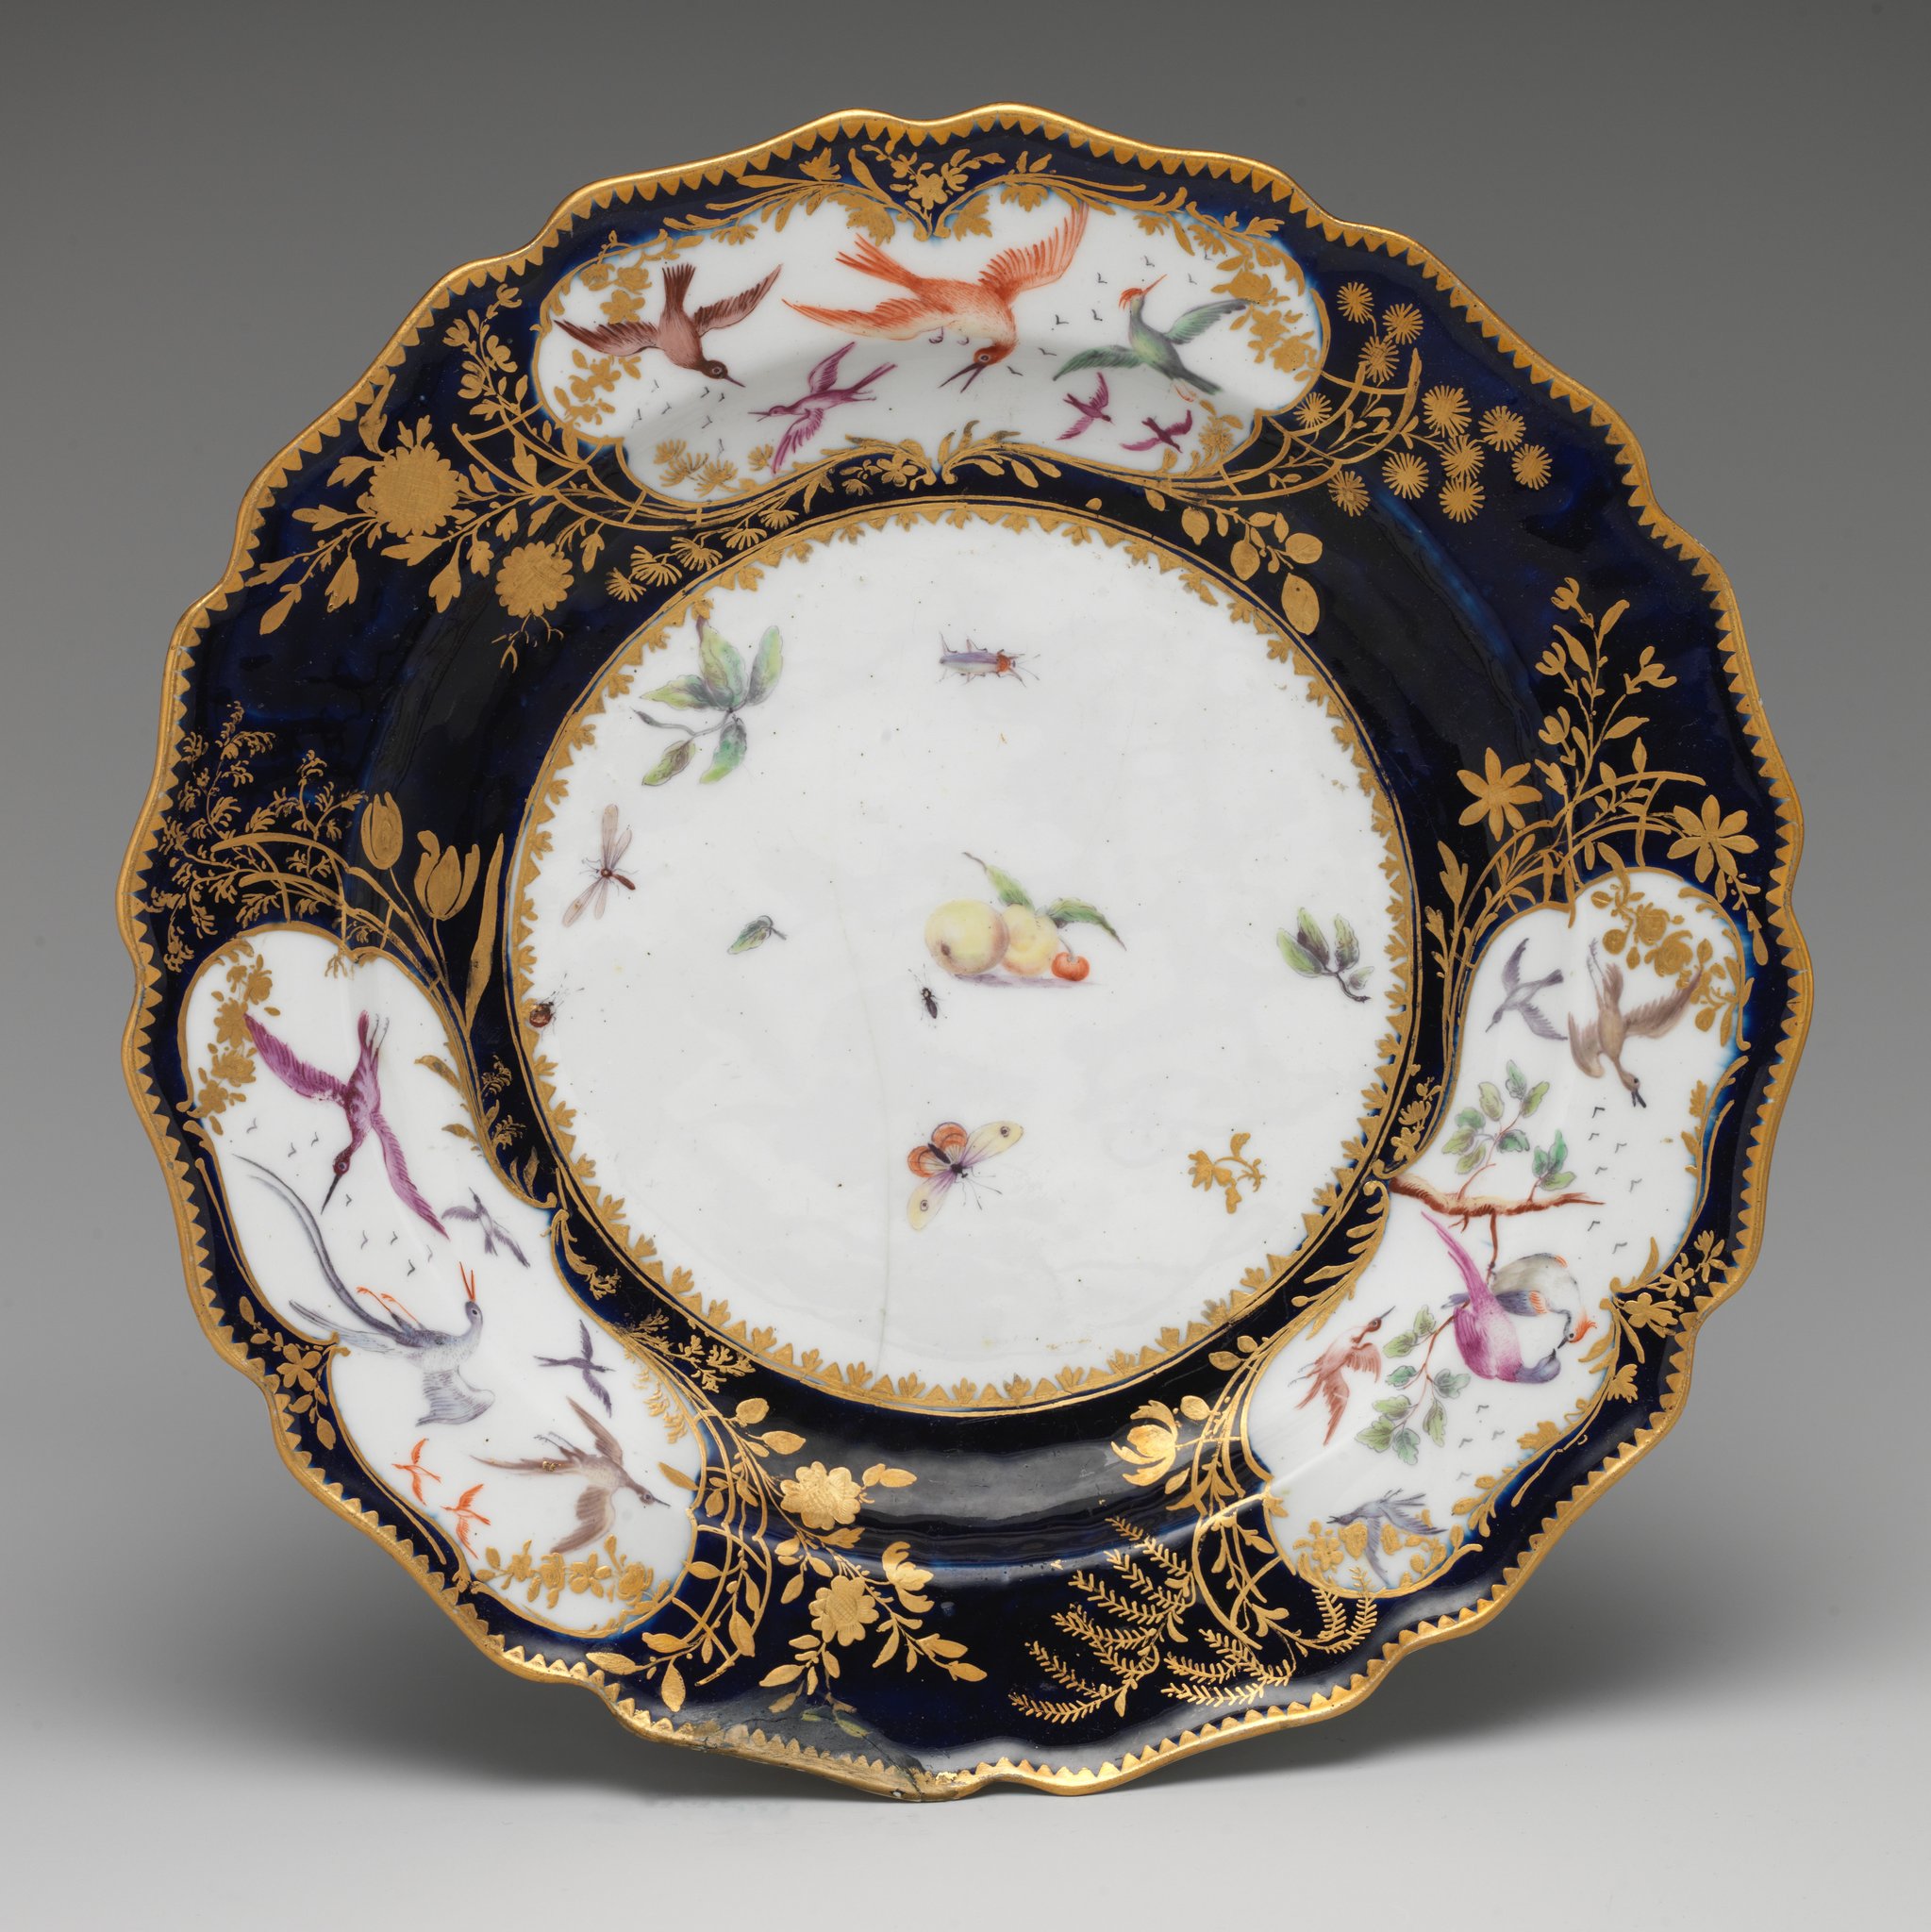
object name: stand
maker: chelsea porcelain manufactory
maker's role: factory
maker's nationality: british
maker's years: 1744-1784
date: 1765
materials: soft paste porcelain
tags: birds